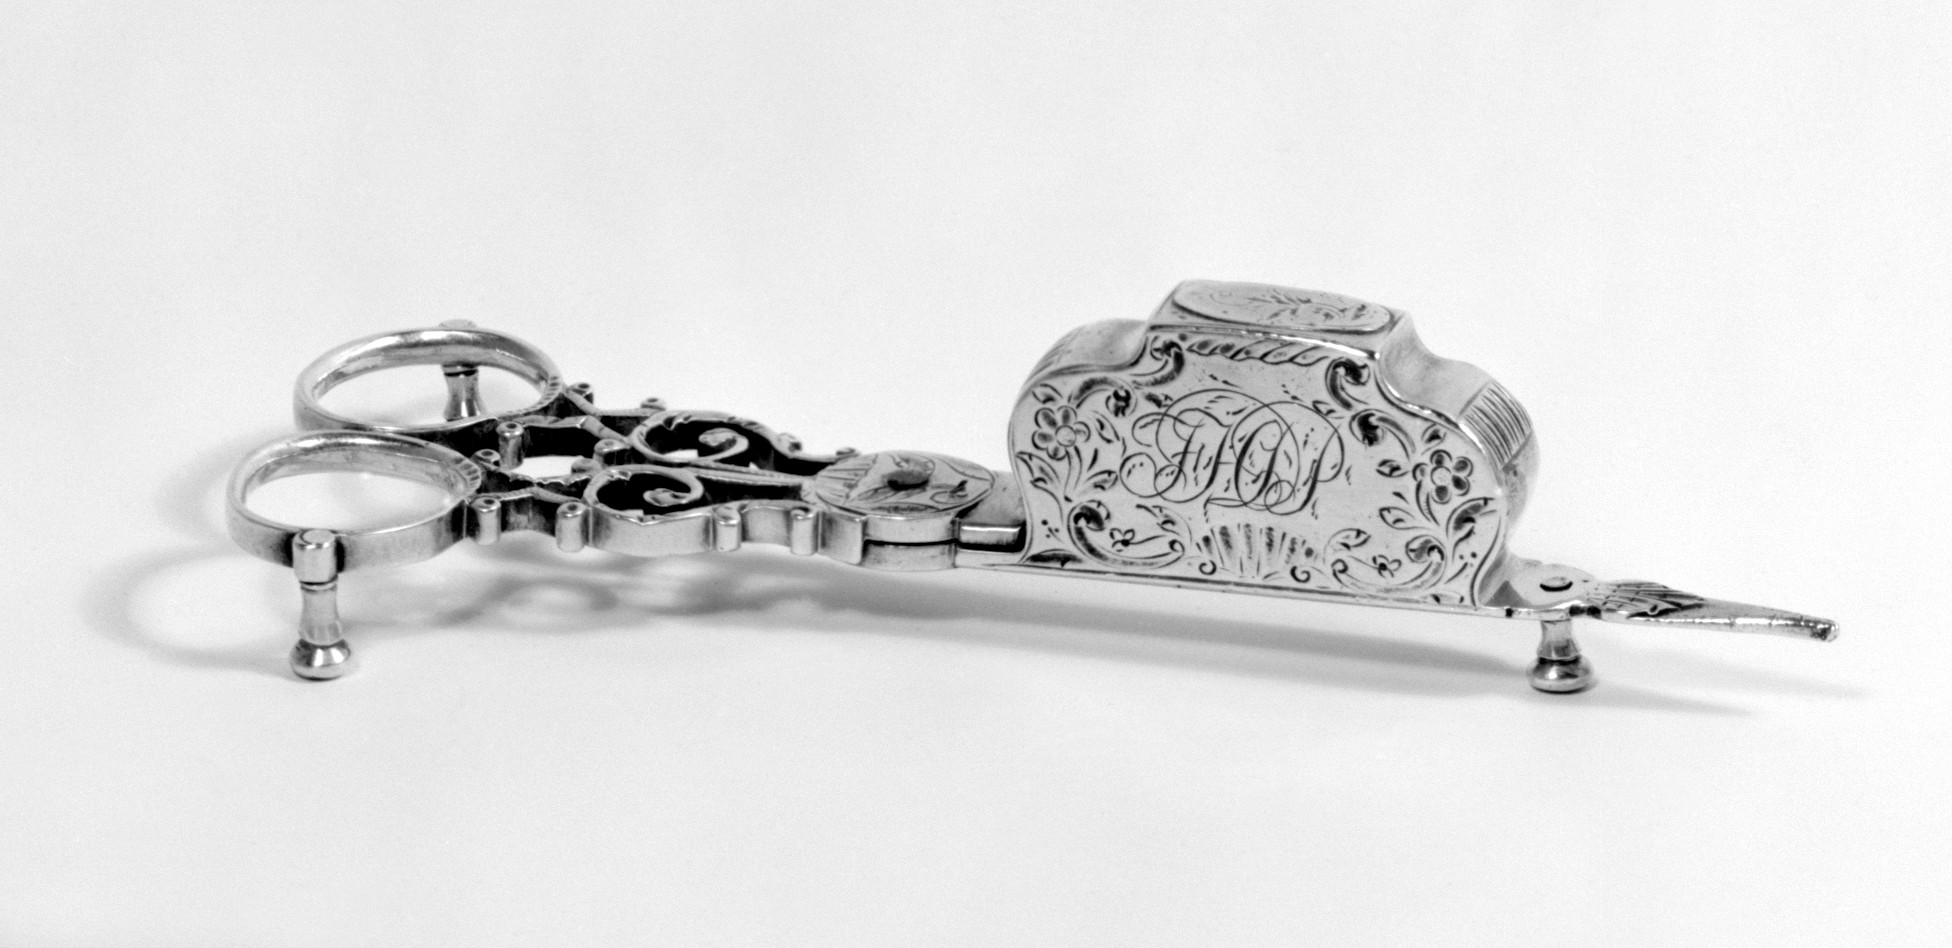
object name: snuffer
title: Snuffers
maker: john buckett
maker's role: maker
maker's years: 1700-1800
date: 1765-1766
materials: silver